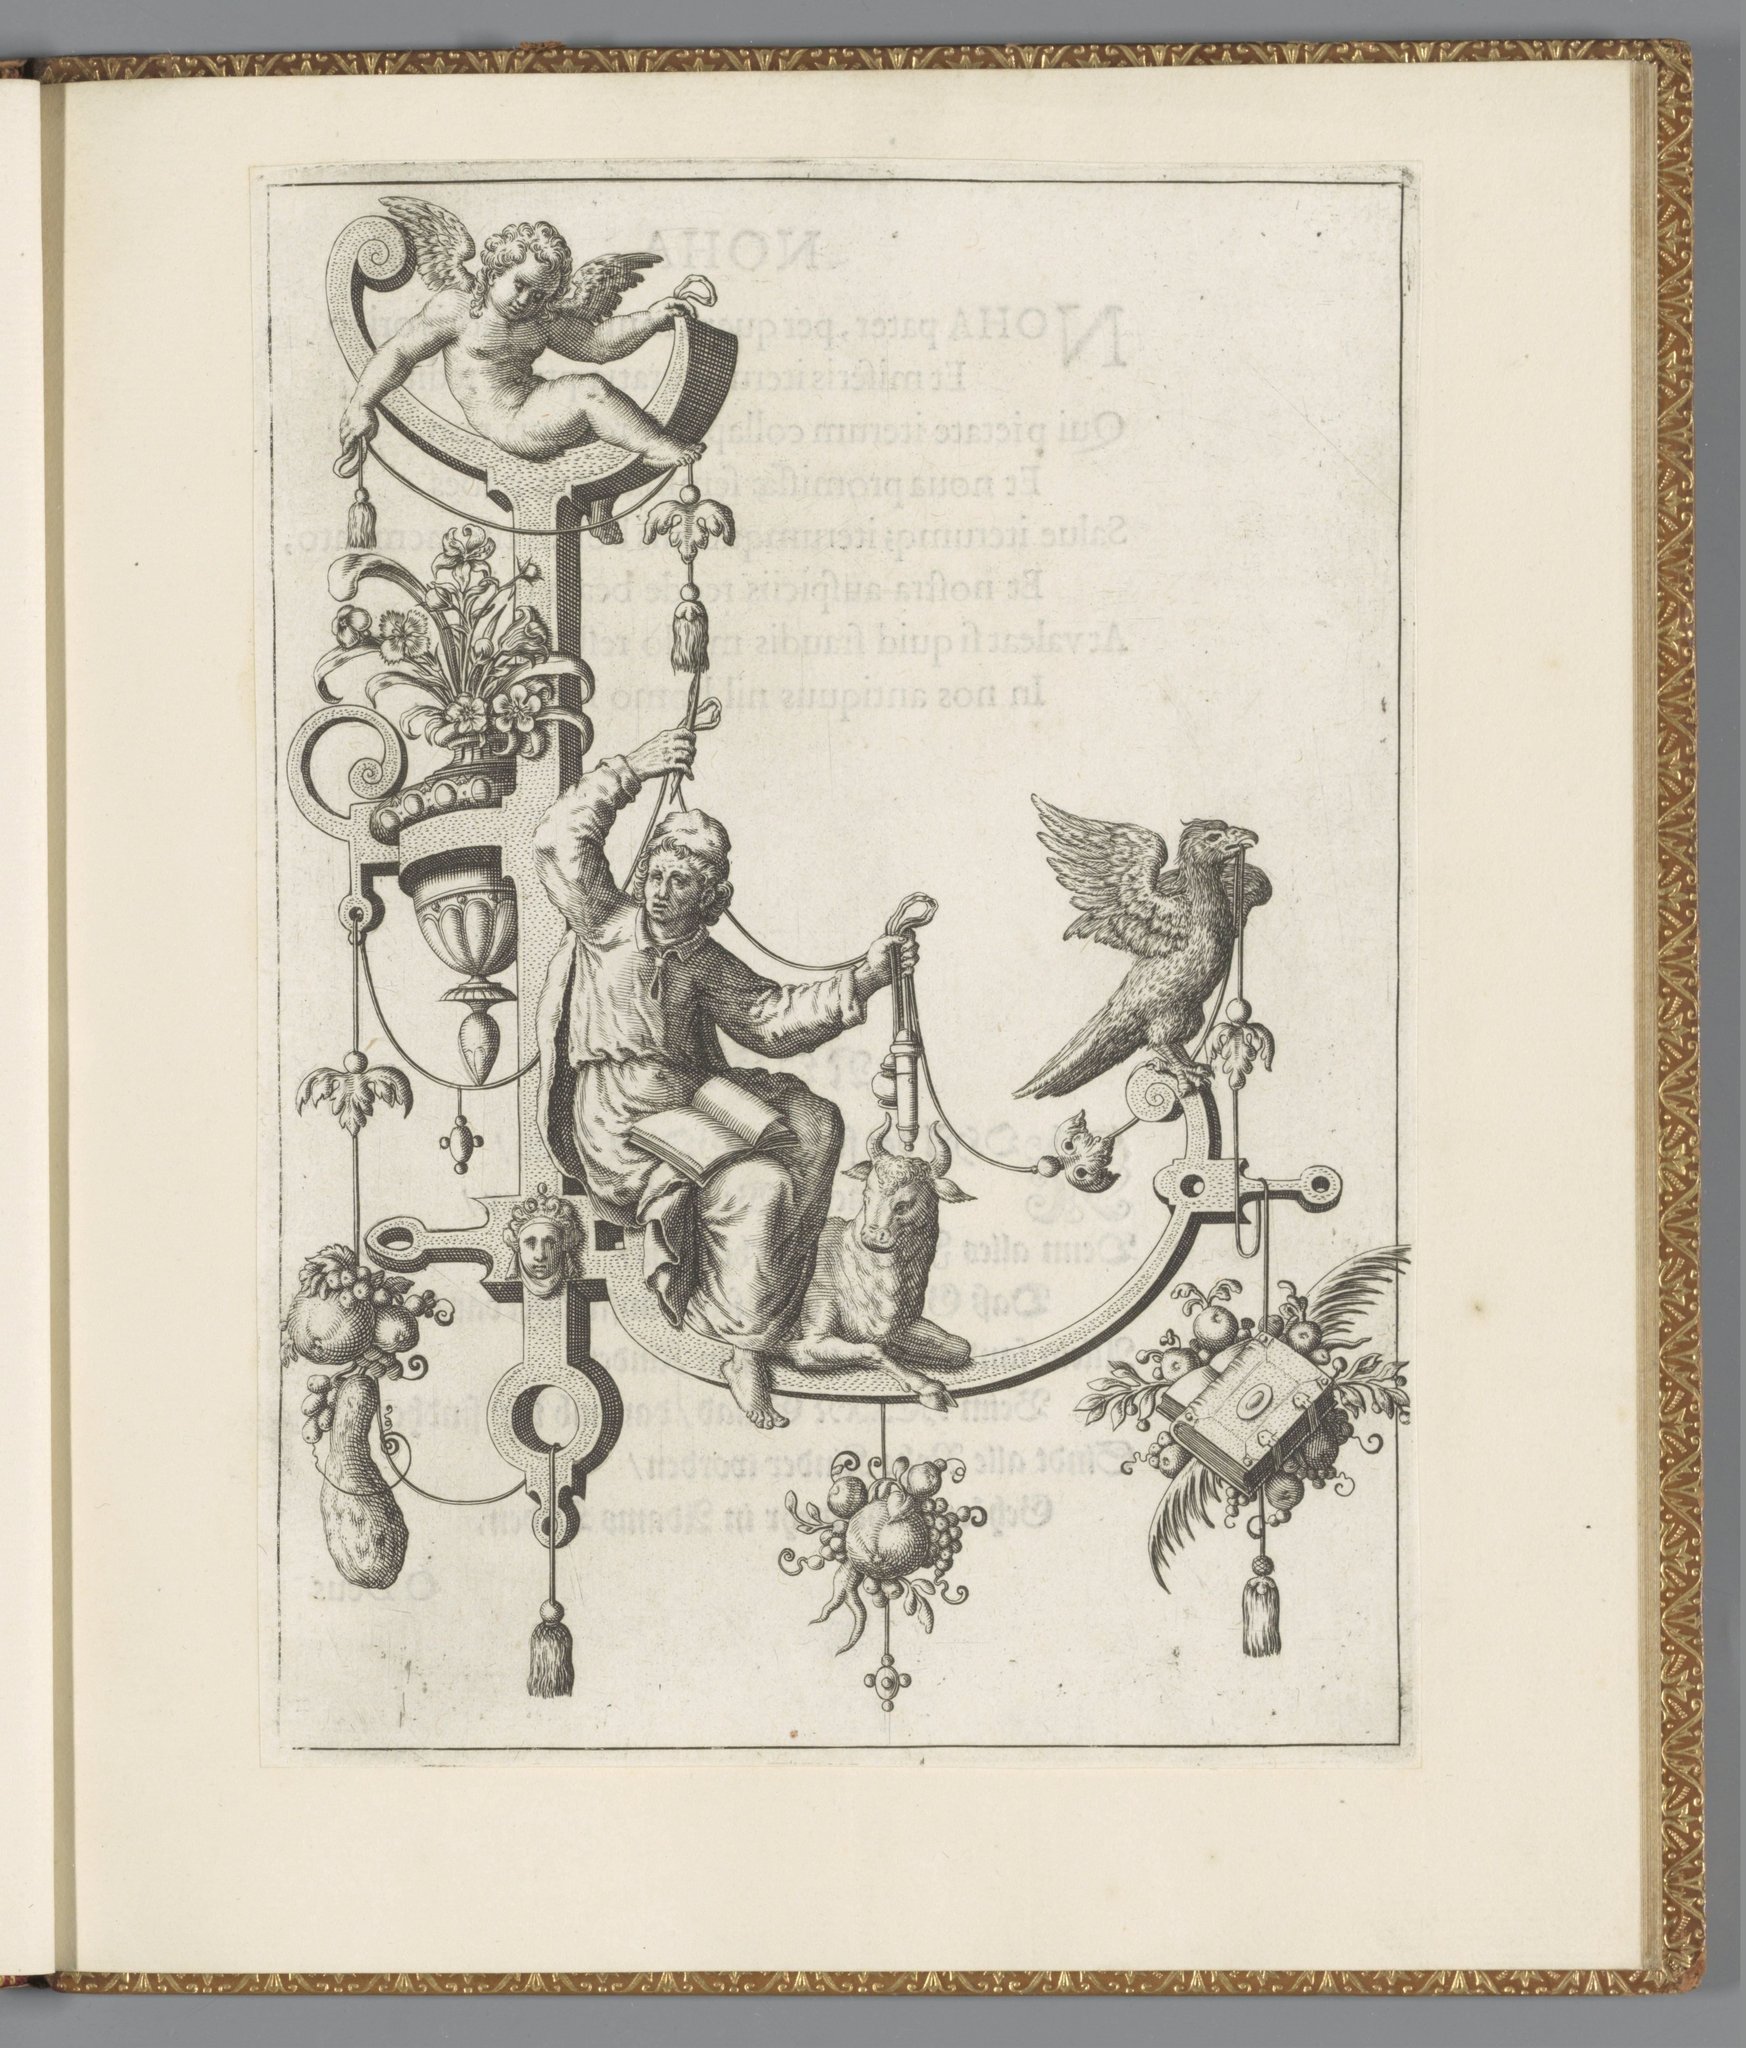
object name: album leaf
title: Nova Alphati Effictio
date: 1595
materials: paper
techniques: engraving, letterpress printing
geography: frankfurt am main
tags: luke the evangelist; possible attributes: book, (winged) ox, portrait of the virgin, surgical instruments, painter's utensils, scroll, fruits and vegetables ~ ornament, letters, alphabet, script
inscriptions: collector's mark: Lugt 2228, collector's mark: Lugt 2760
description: Ornamentele letter L met daarop de evangelist Lukas met schrijfveer in de ene hand en pennenkoker en inktpot in de andere hand. Naast hem de os. De letter wordt bekroond door een gevleugelde putto. Links een vaas met bloemen. Rechtsonder een open en gesloten boek. De letter is verder versierd met een vogel en trossen vruchten. Op verso verzen in het Latijn en het Duits. Prent maakt deel uit van een album.